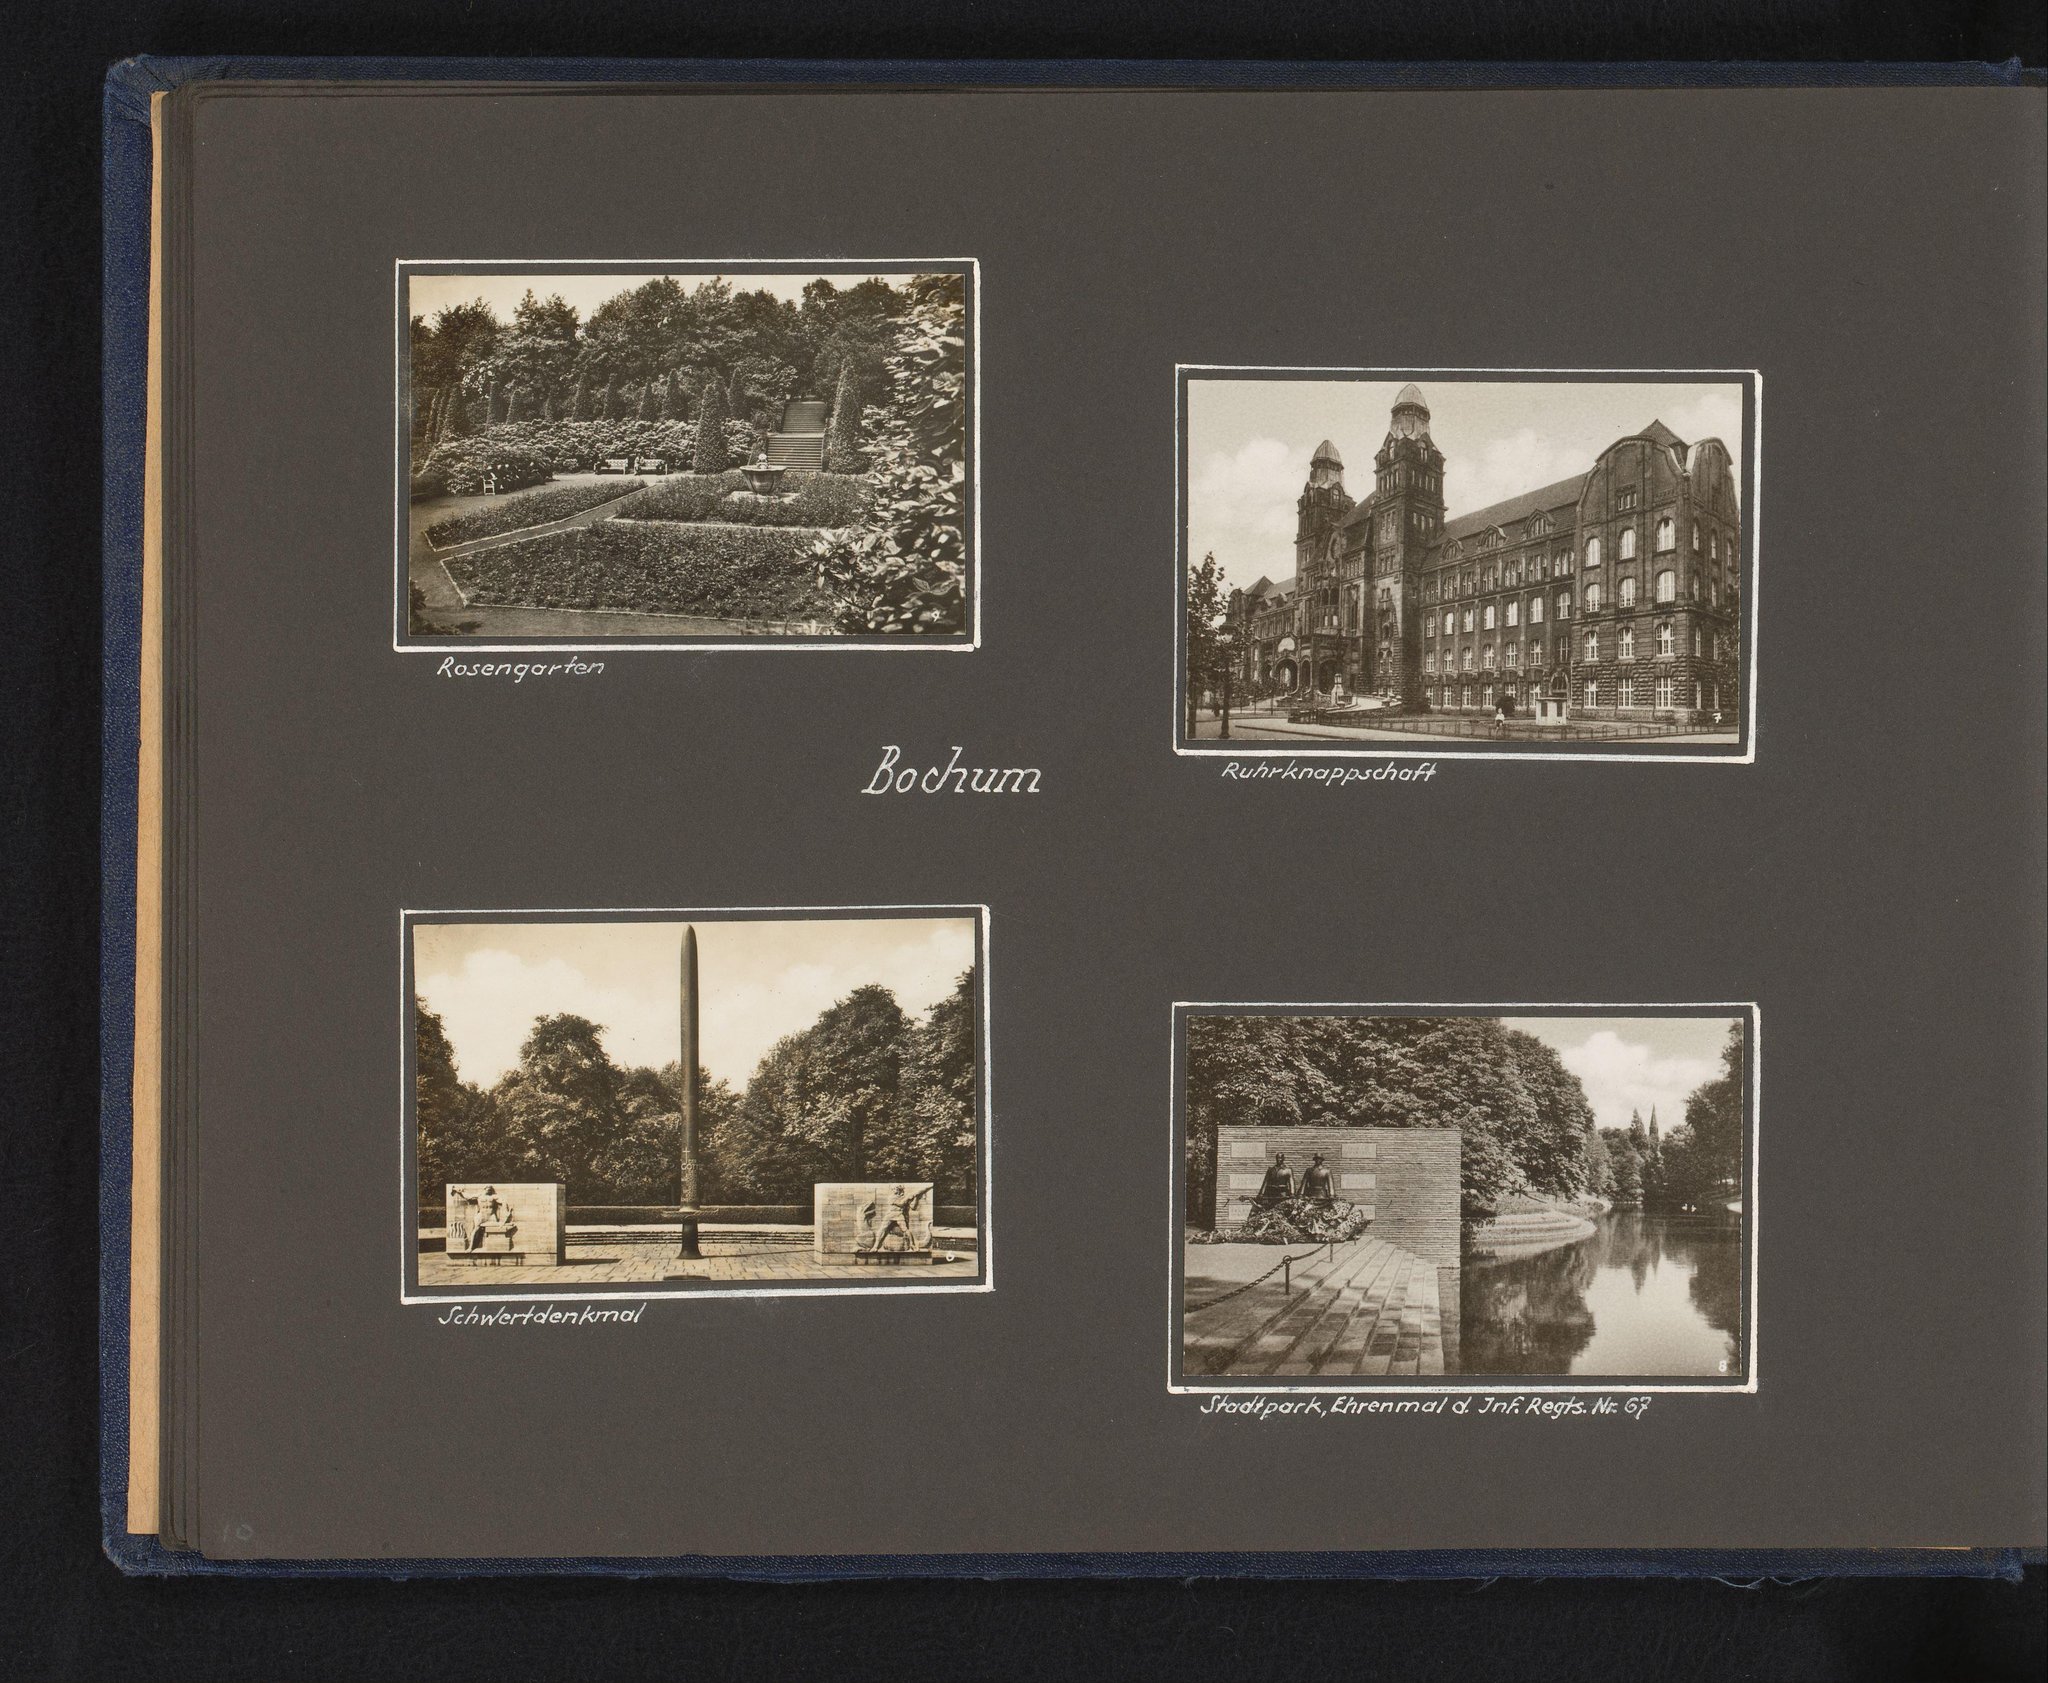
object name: photograph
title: Bochum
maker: Anonymous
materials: paper, photographic support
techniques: gelatin silver print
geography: bochum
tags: city-view in general; 'veduta', the soldier off duty, germany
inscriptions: inscription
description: Albumblad met vier (gekochte) foto's met bezienswaardigheden in Bochum, waaronder het 'Schwertdenkmal', eind 1939. Onderdeel van een Duits militair album Tweede Wereldoorlog 1939-1940.